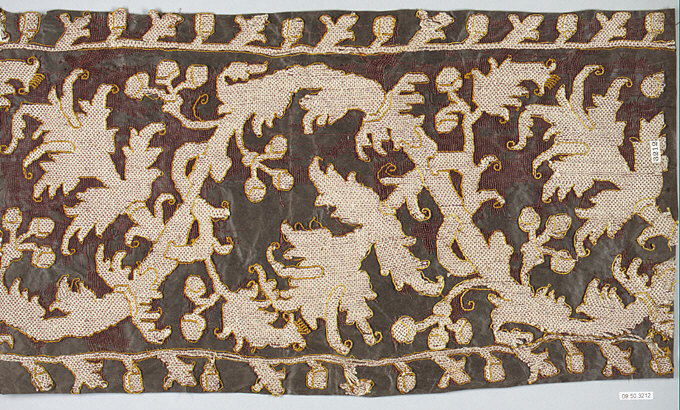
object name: fragment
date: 1601-1700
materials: silk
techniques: embroidery